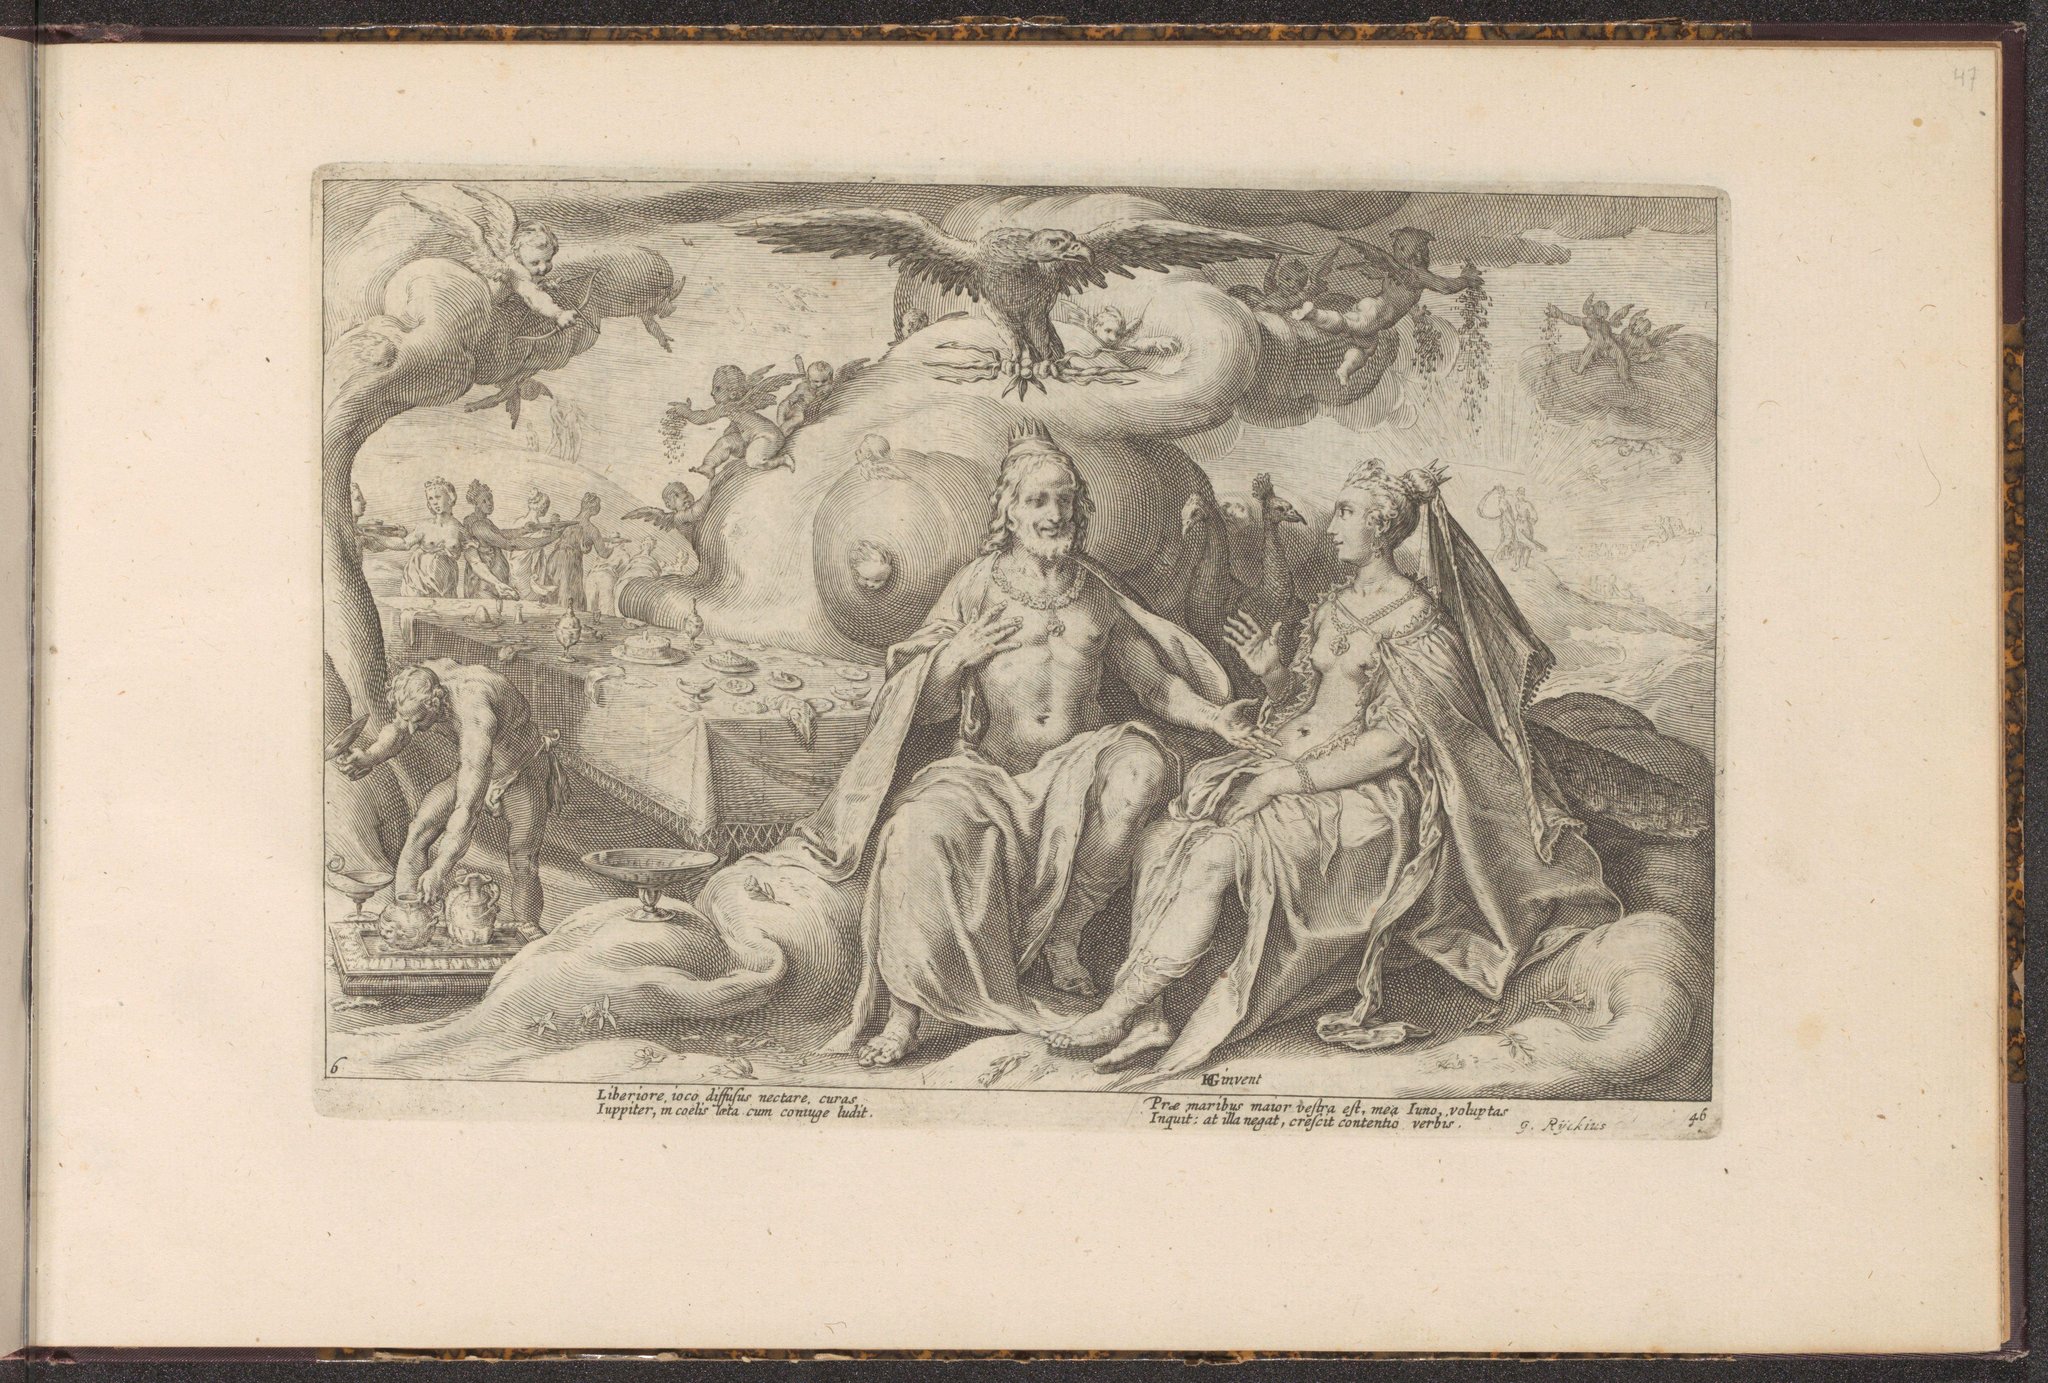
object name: print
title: Jupiter en Juno discussiëren over de vraag bij welke van de seksen de lust in liefde groter is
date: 1615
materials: paper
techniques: engraving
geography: amsterdam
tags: (story of) juno (hera), (story of) jupiter (zeus)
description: Jupiter en Juno zitten naast elkaar, voor een lange tafel die juist wordt afgeruimd, en discussiëren over de vraag bij welke van de seksen de lust in liefde groter is. Jupiter stelt dat dat het voorrecht van de vrouw is, Juno spreekt hem tegen.Onder de voorstelling twee keer twee versregels in het Latijn. De prent maakt deel uit van een album.